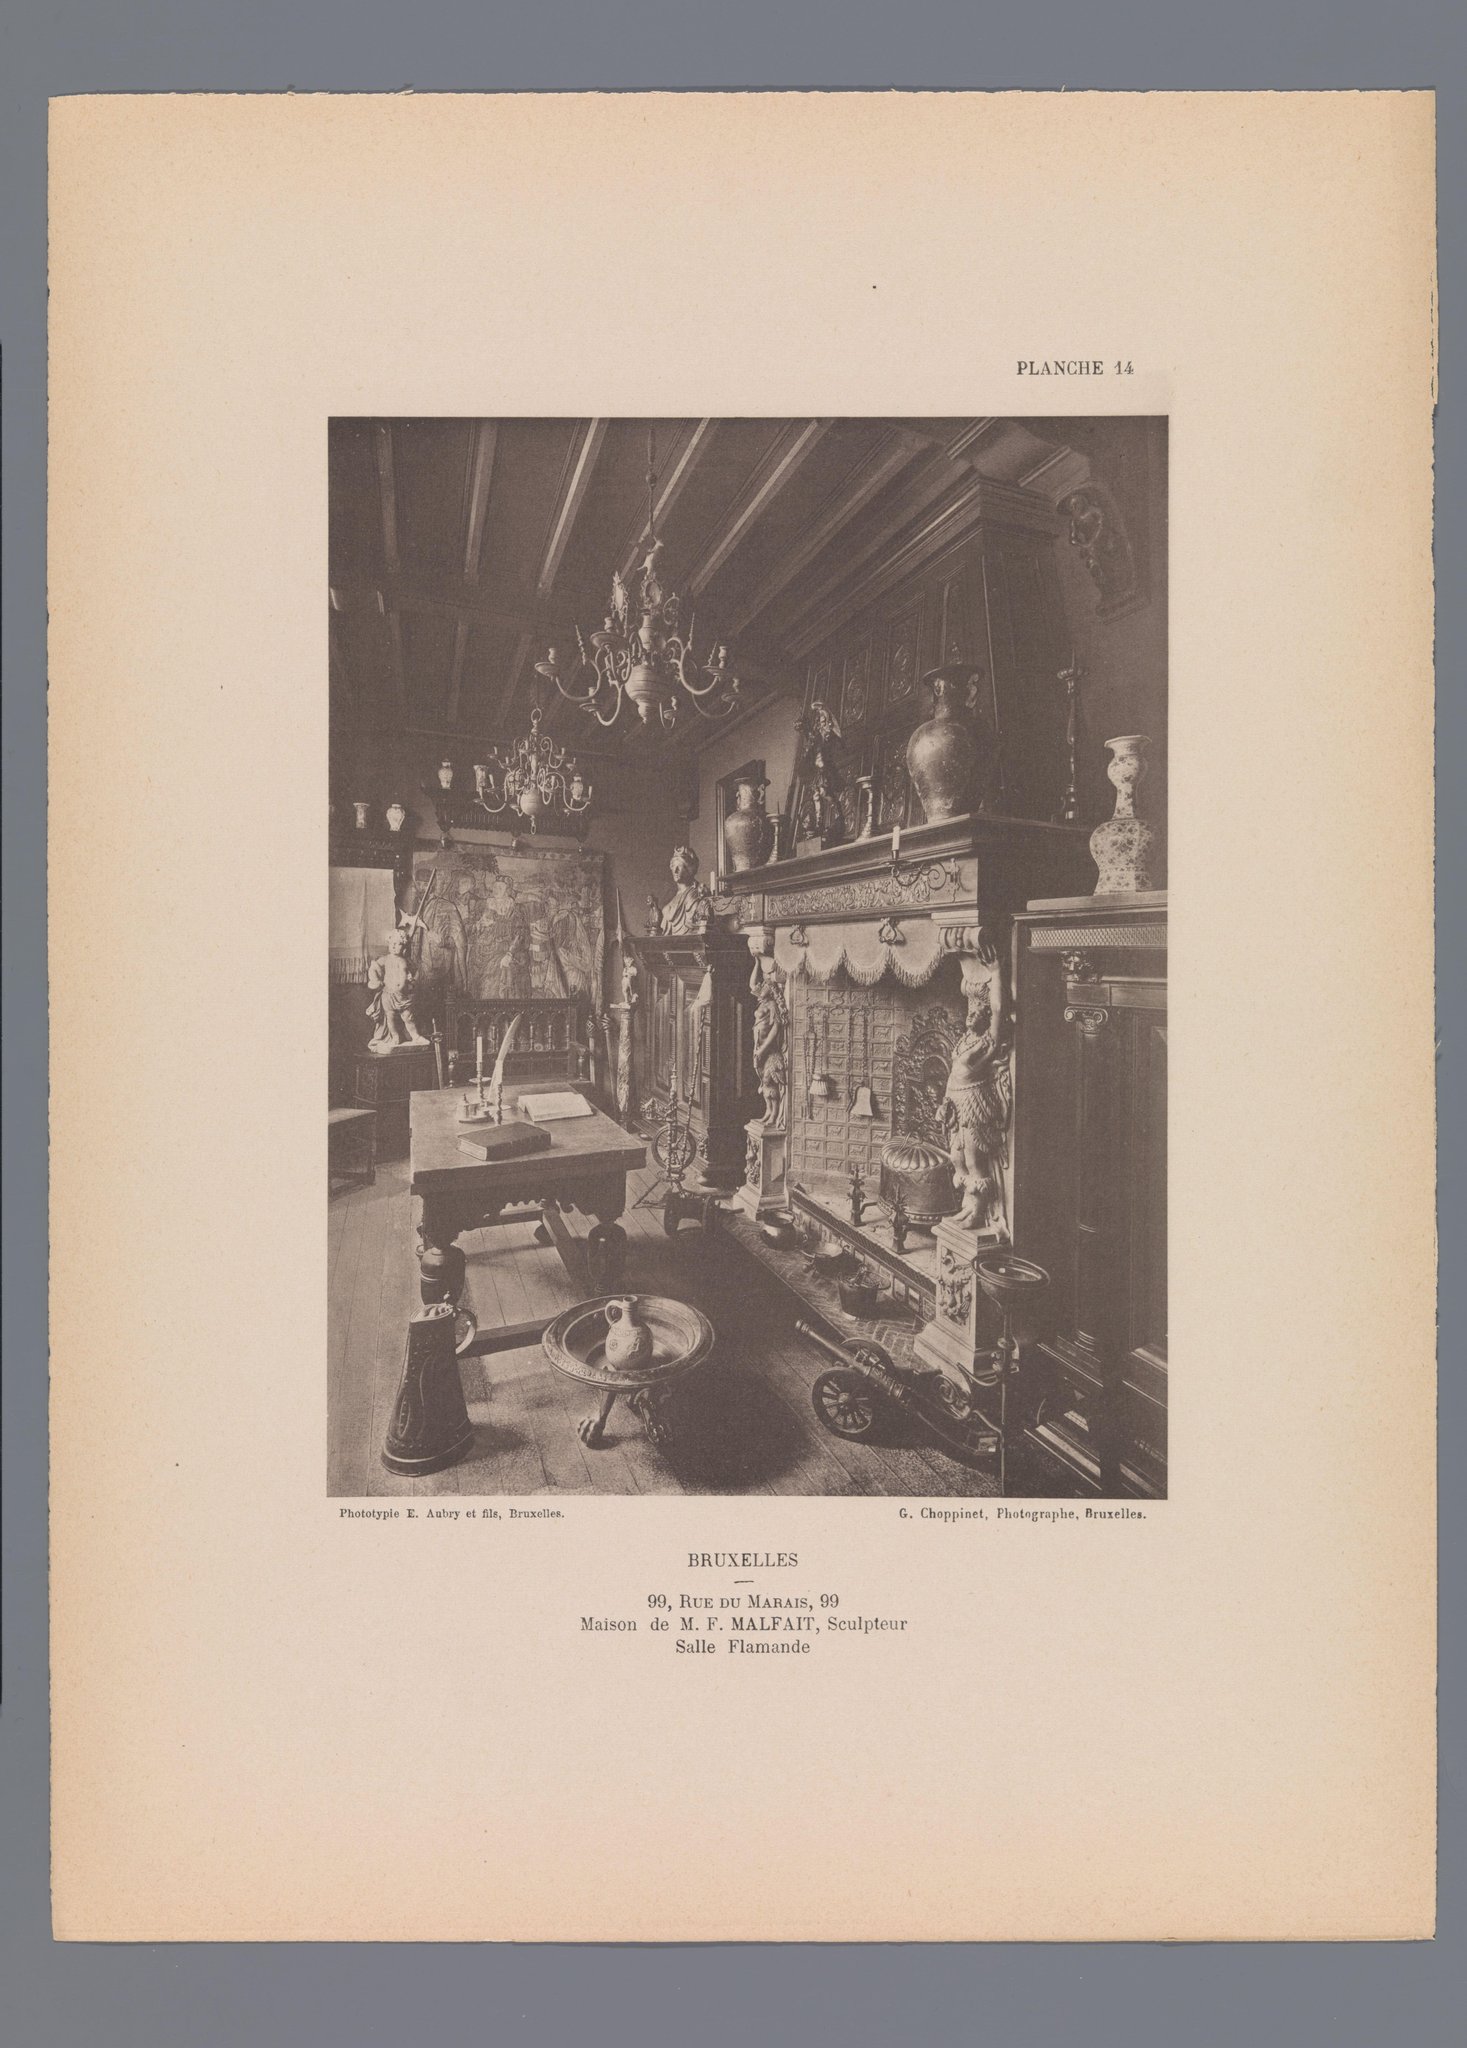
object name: photomechanical print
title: Bruxelles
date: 1893-1898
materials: paper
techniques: photograph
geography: brussels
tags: interior of the house, brussels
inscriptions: inscription: ‘99, Rue du Marais, 99/ Maison de M. F. Malfait, Sculpteur/ Salle Flamande’, number: ‘PLANCHE 14’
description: Deze prent maakt deel uit van een omslag met 89 prenten en 5 tekstbladen.